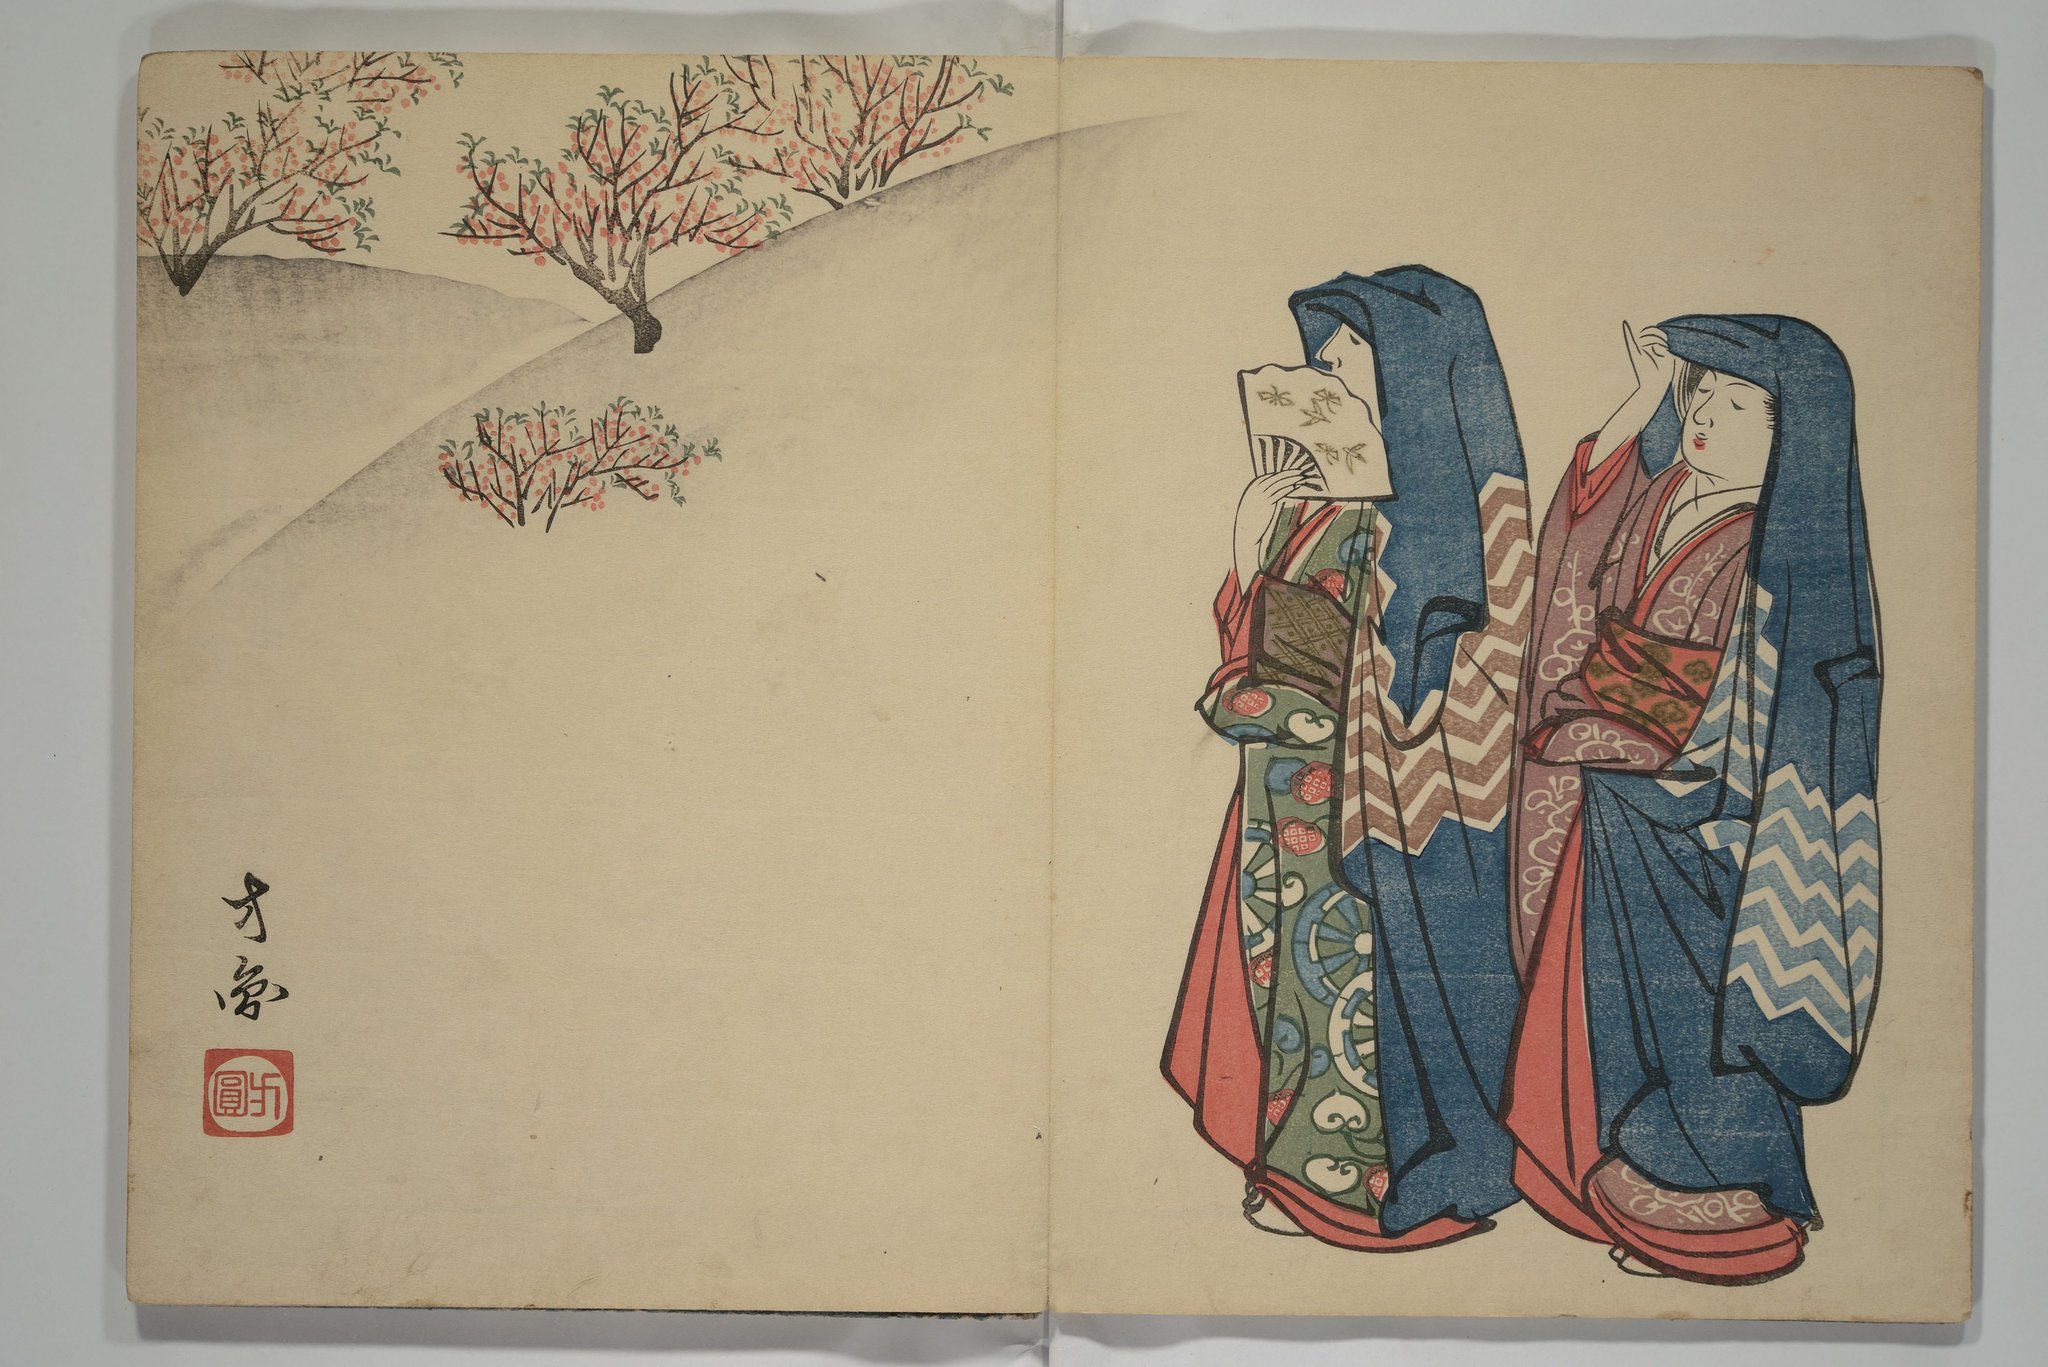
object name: illustrated book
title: Album of the Phoenix Bird (Ranpō jō) 鸞鳳帖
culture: japanese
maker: keian tenrai 桂庵天籟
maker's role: artist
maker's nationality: japanese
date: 1806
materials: ink, paper, pigment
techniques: woodblock print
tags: fans,women